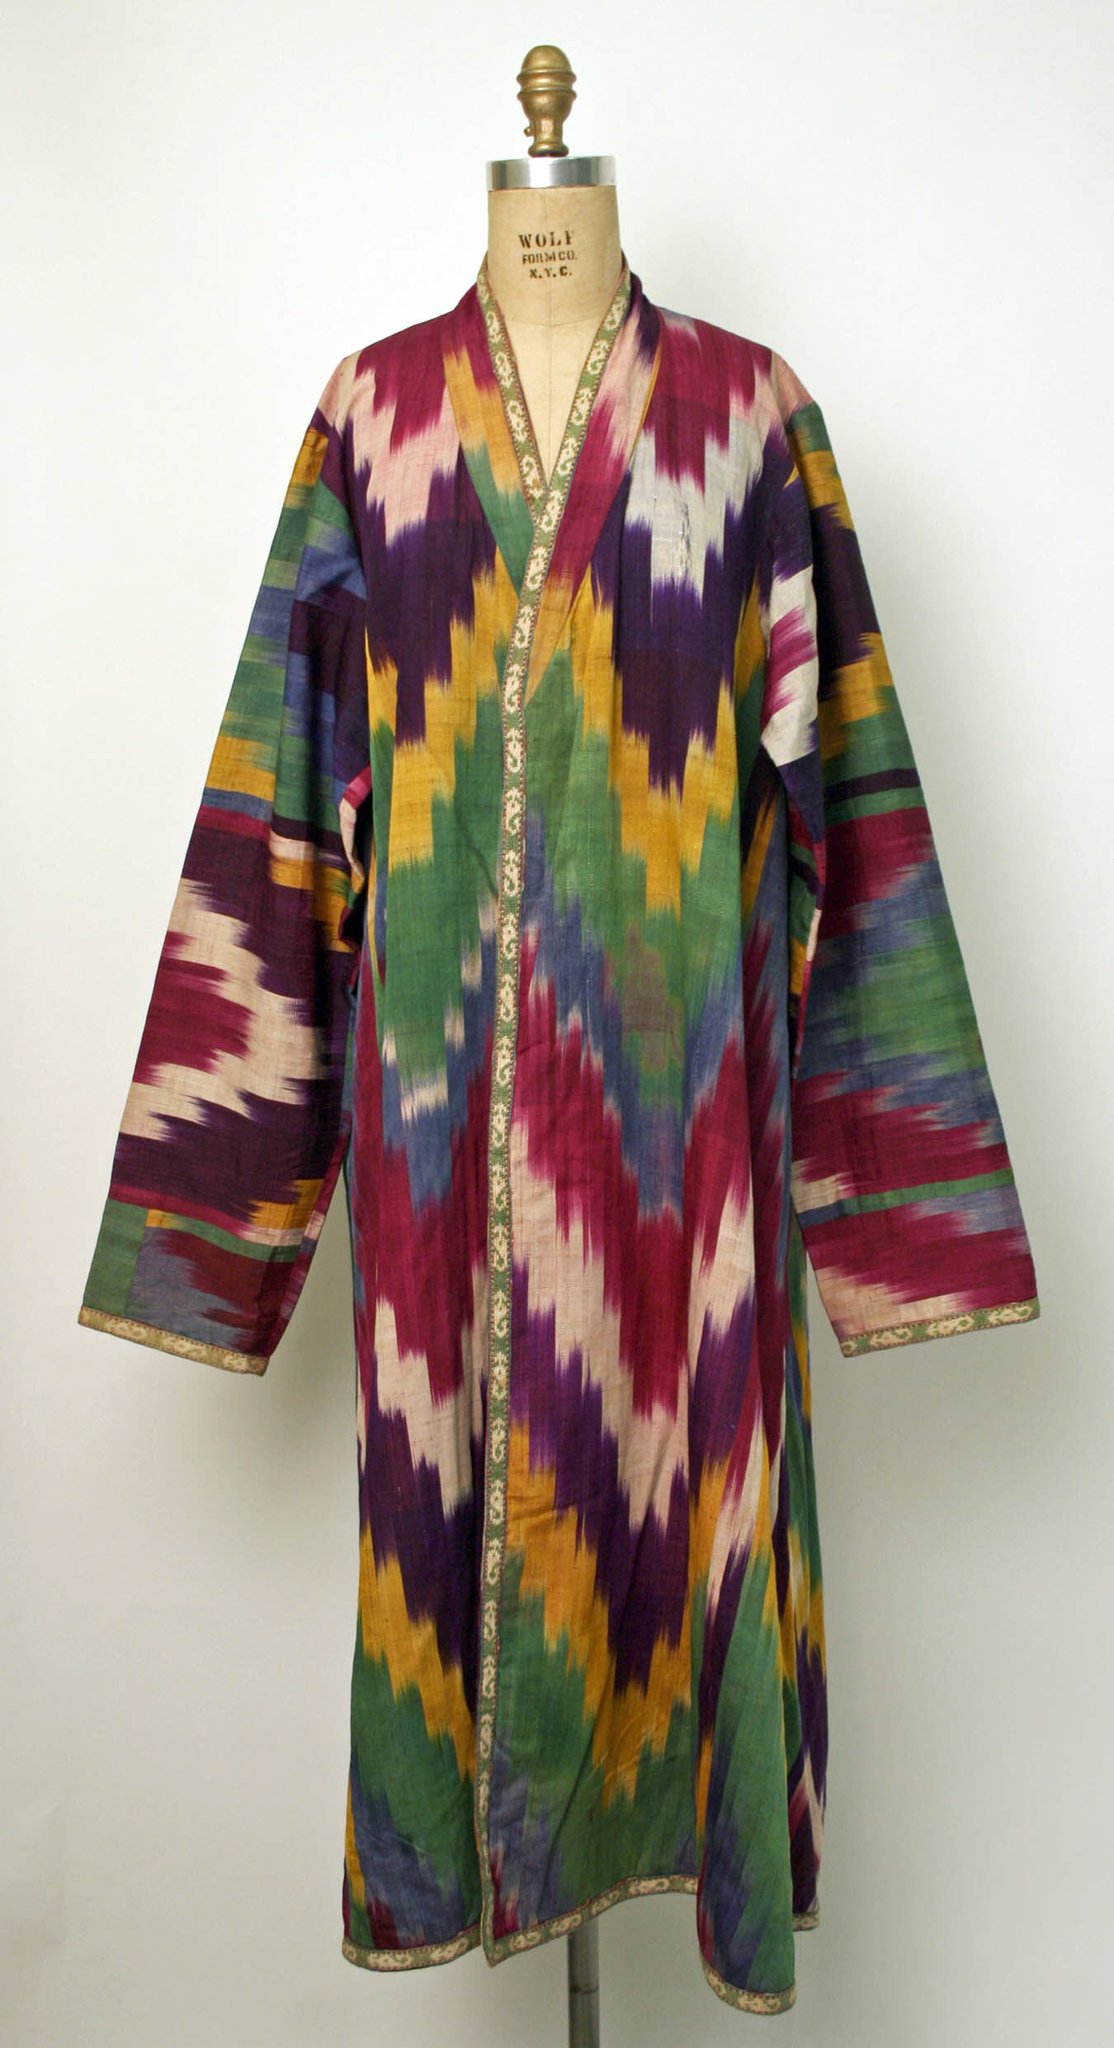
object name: robe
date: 1801-1900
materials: cotton, silk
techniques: weave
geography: uzbekistan